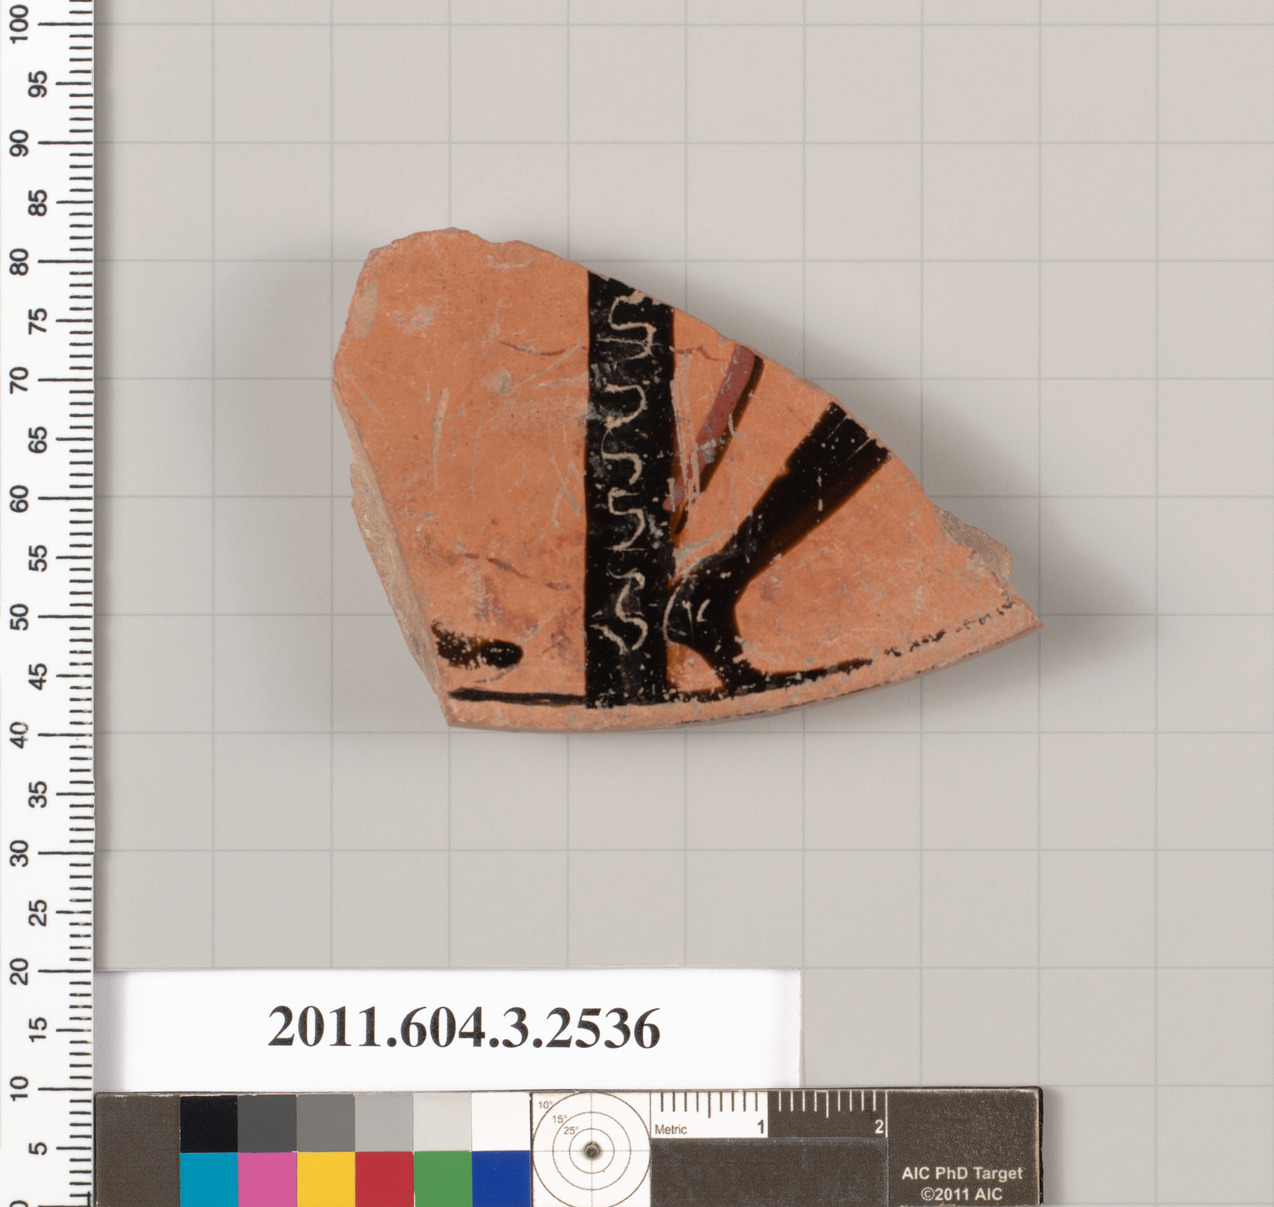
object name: kylix fragment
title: Terracotta fragment of a kylix (drinking cup)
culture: greek, attic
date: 525-501 BCE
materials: terracotta